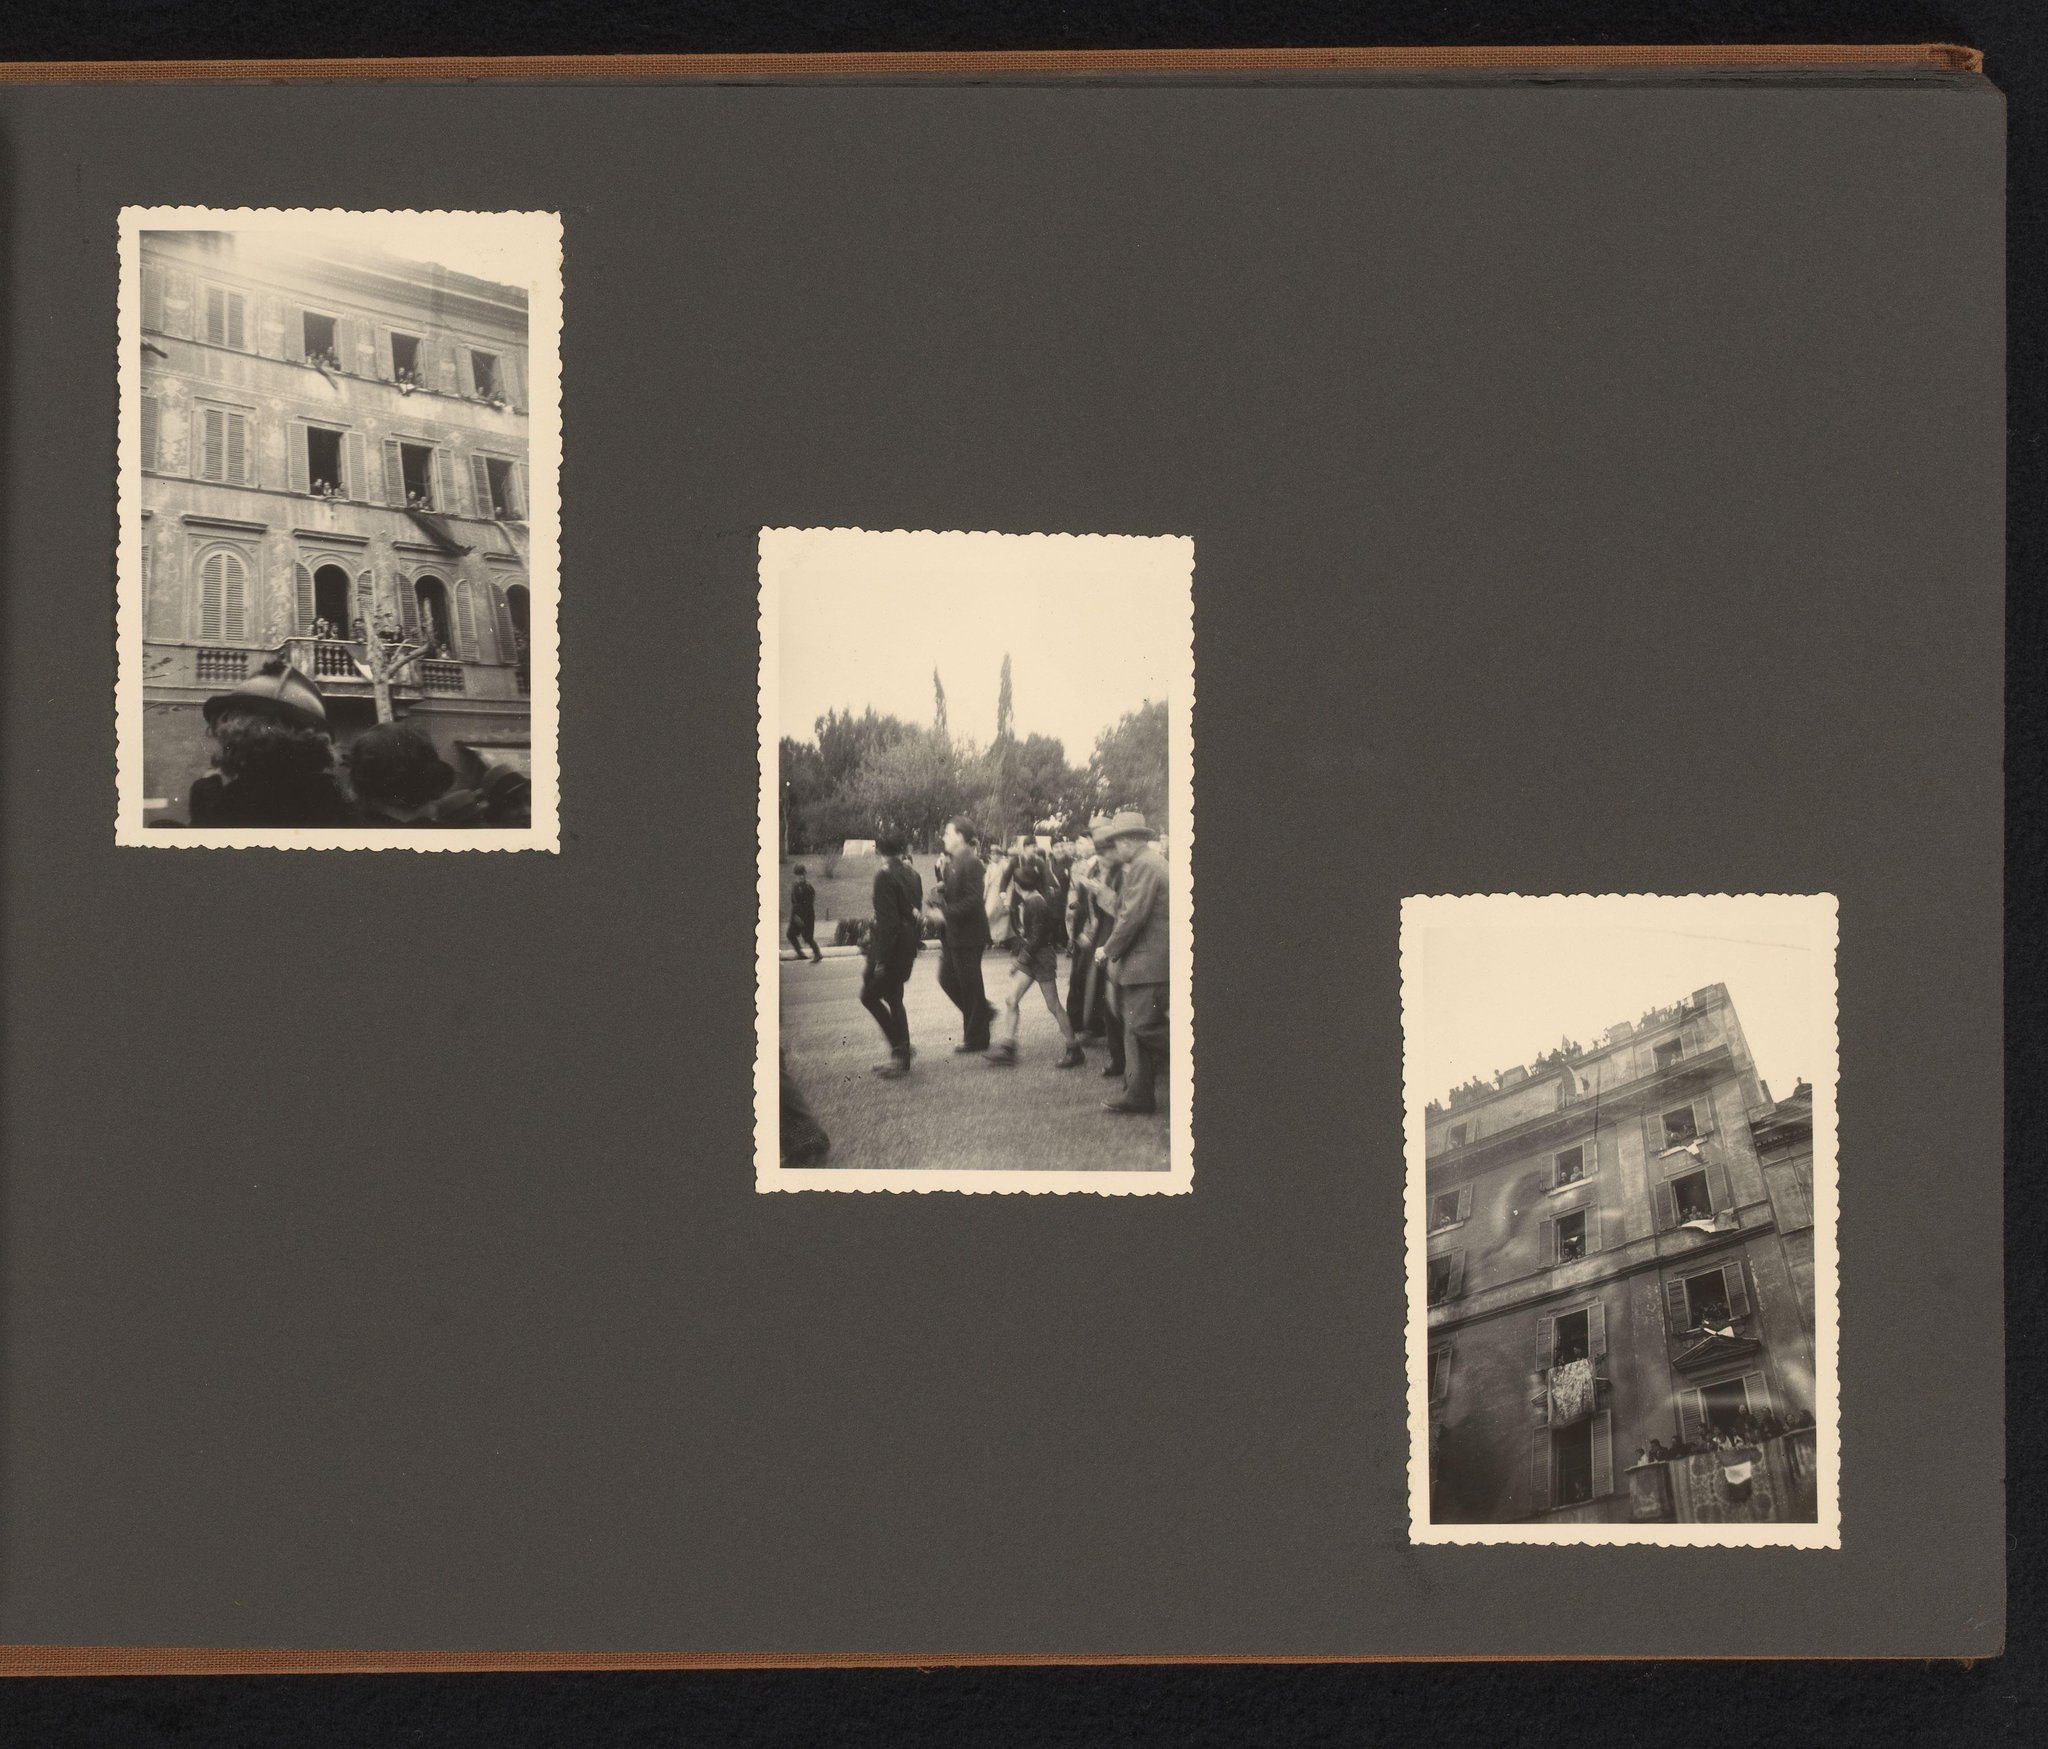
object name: album leaf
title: Optocht door de straten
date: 1936-1939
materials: cardboard, paper, photographic support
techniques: gelatin silver print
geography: rome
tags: urban housing, street (+ city(-scape) with figures, staffage), rome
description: Drie foto's gemaakt tijdens de vakantie van Berti Hoppe en Herman Besselaar naar Rome, twee van toekijkende mensen en één van de stoet. Deze pagina maakt deel uit van een album.